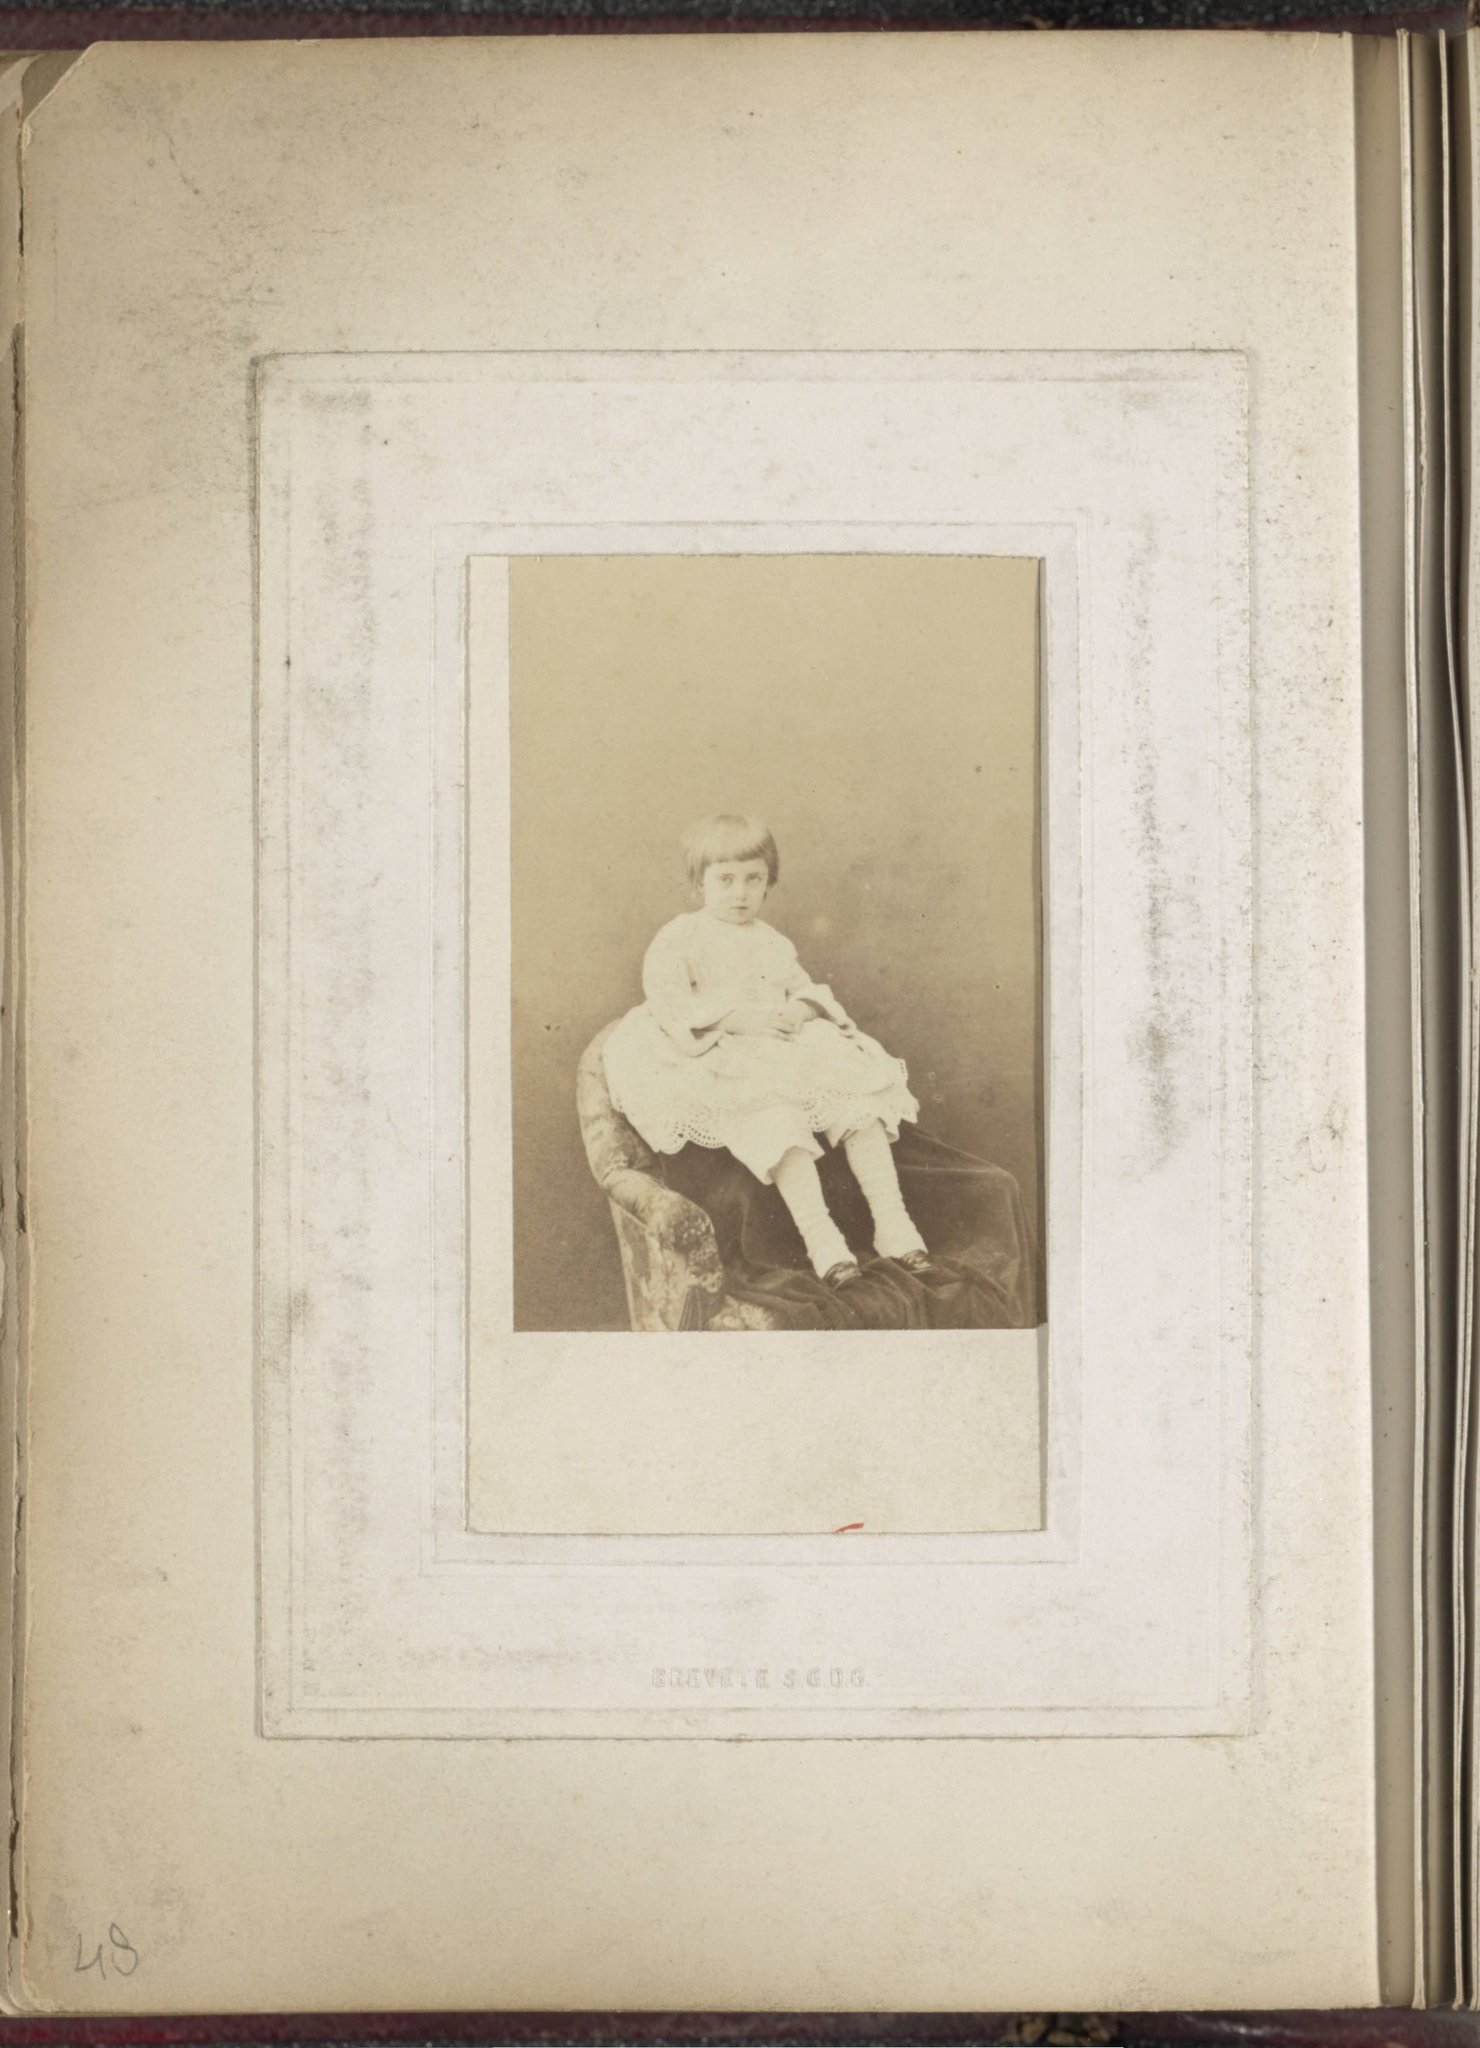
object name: photograph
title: Cartes-de-visite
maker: Anonymous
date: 1860-1865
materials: cardboard, paper, photographic support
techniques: albumen print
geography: paris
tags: studio requisites ~ photographer, shoes, sandals (+ children's clothes), dress, gown (+ children's clothes), stockings, socks (+ children's clothes), child, historical persons, styles of hairdress - aa - ~ women, chair, paris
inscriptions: address: ‘N. 35, Boult. des Capucines, Paris’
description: Cartomanie was a collecting craze. From 1855 hundreds of thousands of these portraits were annually sold worldwide. People had photographs taken of their loved ones, including their pets, and kept them in an album. Portraits of kings, writers, artists, actors, and statesmen were also collected. Photography was no longer the preserve of the wealthy; farmers and maidservants now also stood before the camera.